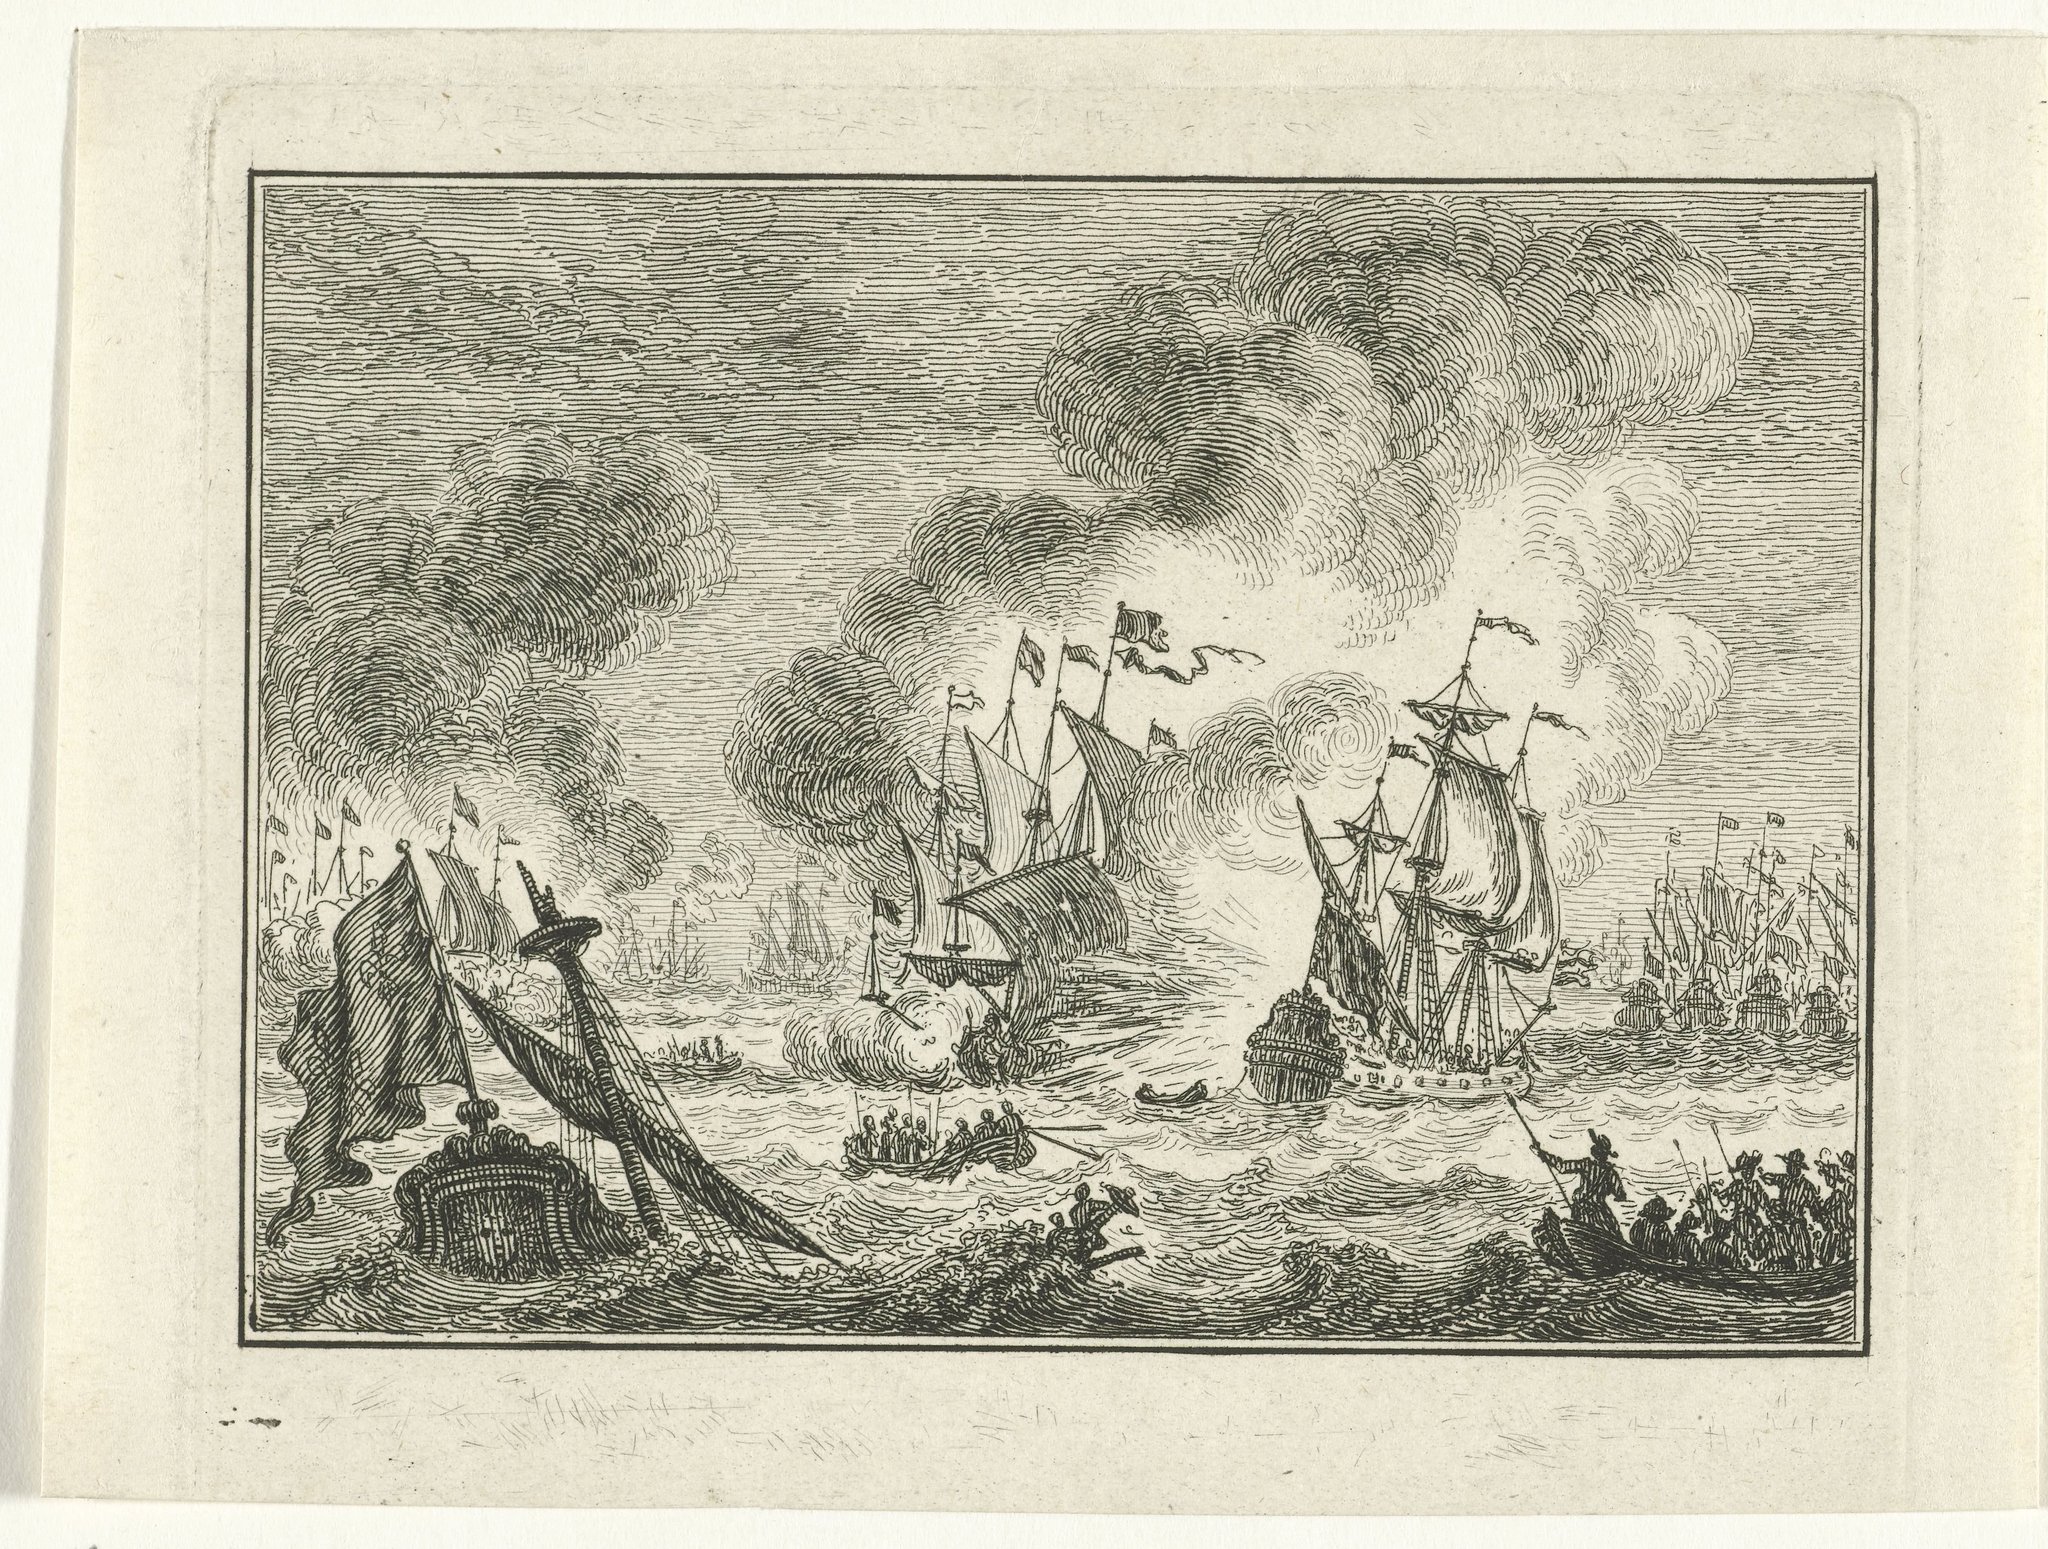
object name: print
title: Zeeslag met zinkende schepen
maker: simon fokke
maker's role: draughtsman, print maker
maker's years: 1712-1784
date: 1722-1784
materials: paper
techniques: etching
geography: amsterdam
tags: battle (+ naval force)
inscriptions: collector's mark: Lugt 2228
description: Voorstelling uit de vaderlandse geschiedenis. Zicht op een zeeslag met op de voorgrond een zinkend zeilschip en een roeiboot met bemanning. In de verte liggen meer zeilschepen, enkele hiervan staan in brand en zijn omgeven door rookwolken.